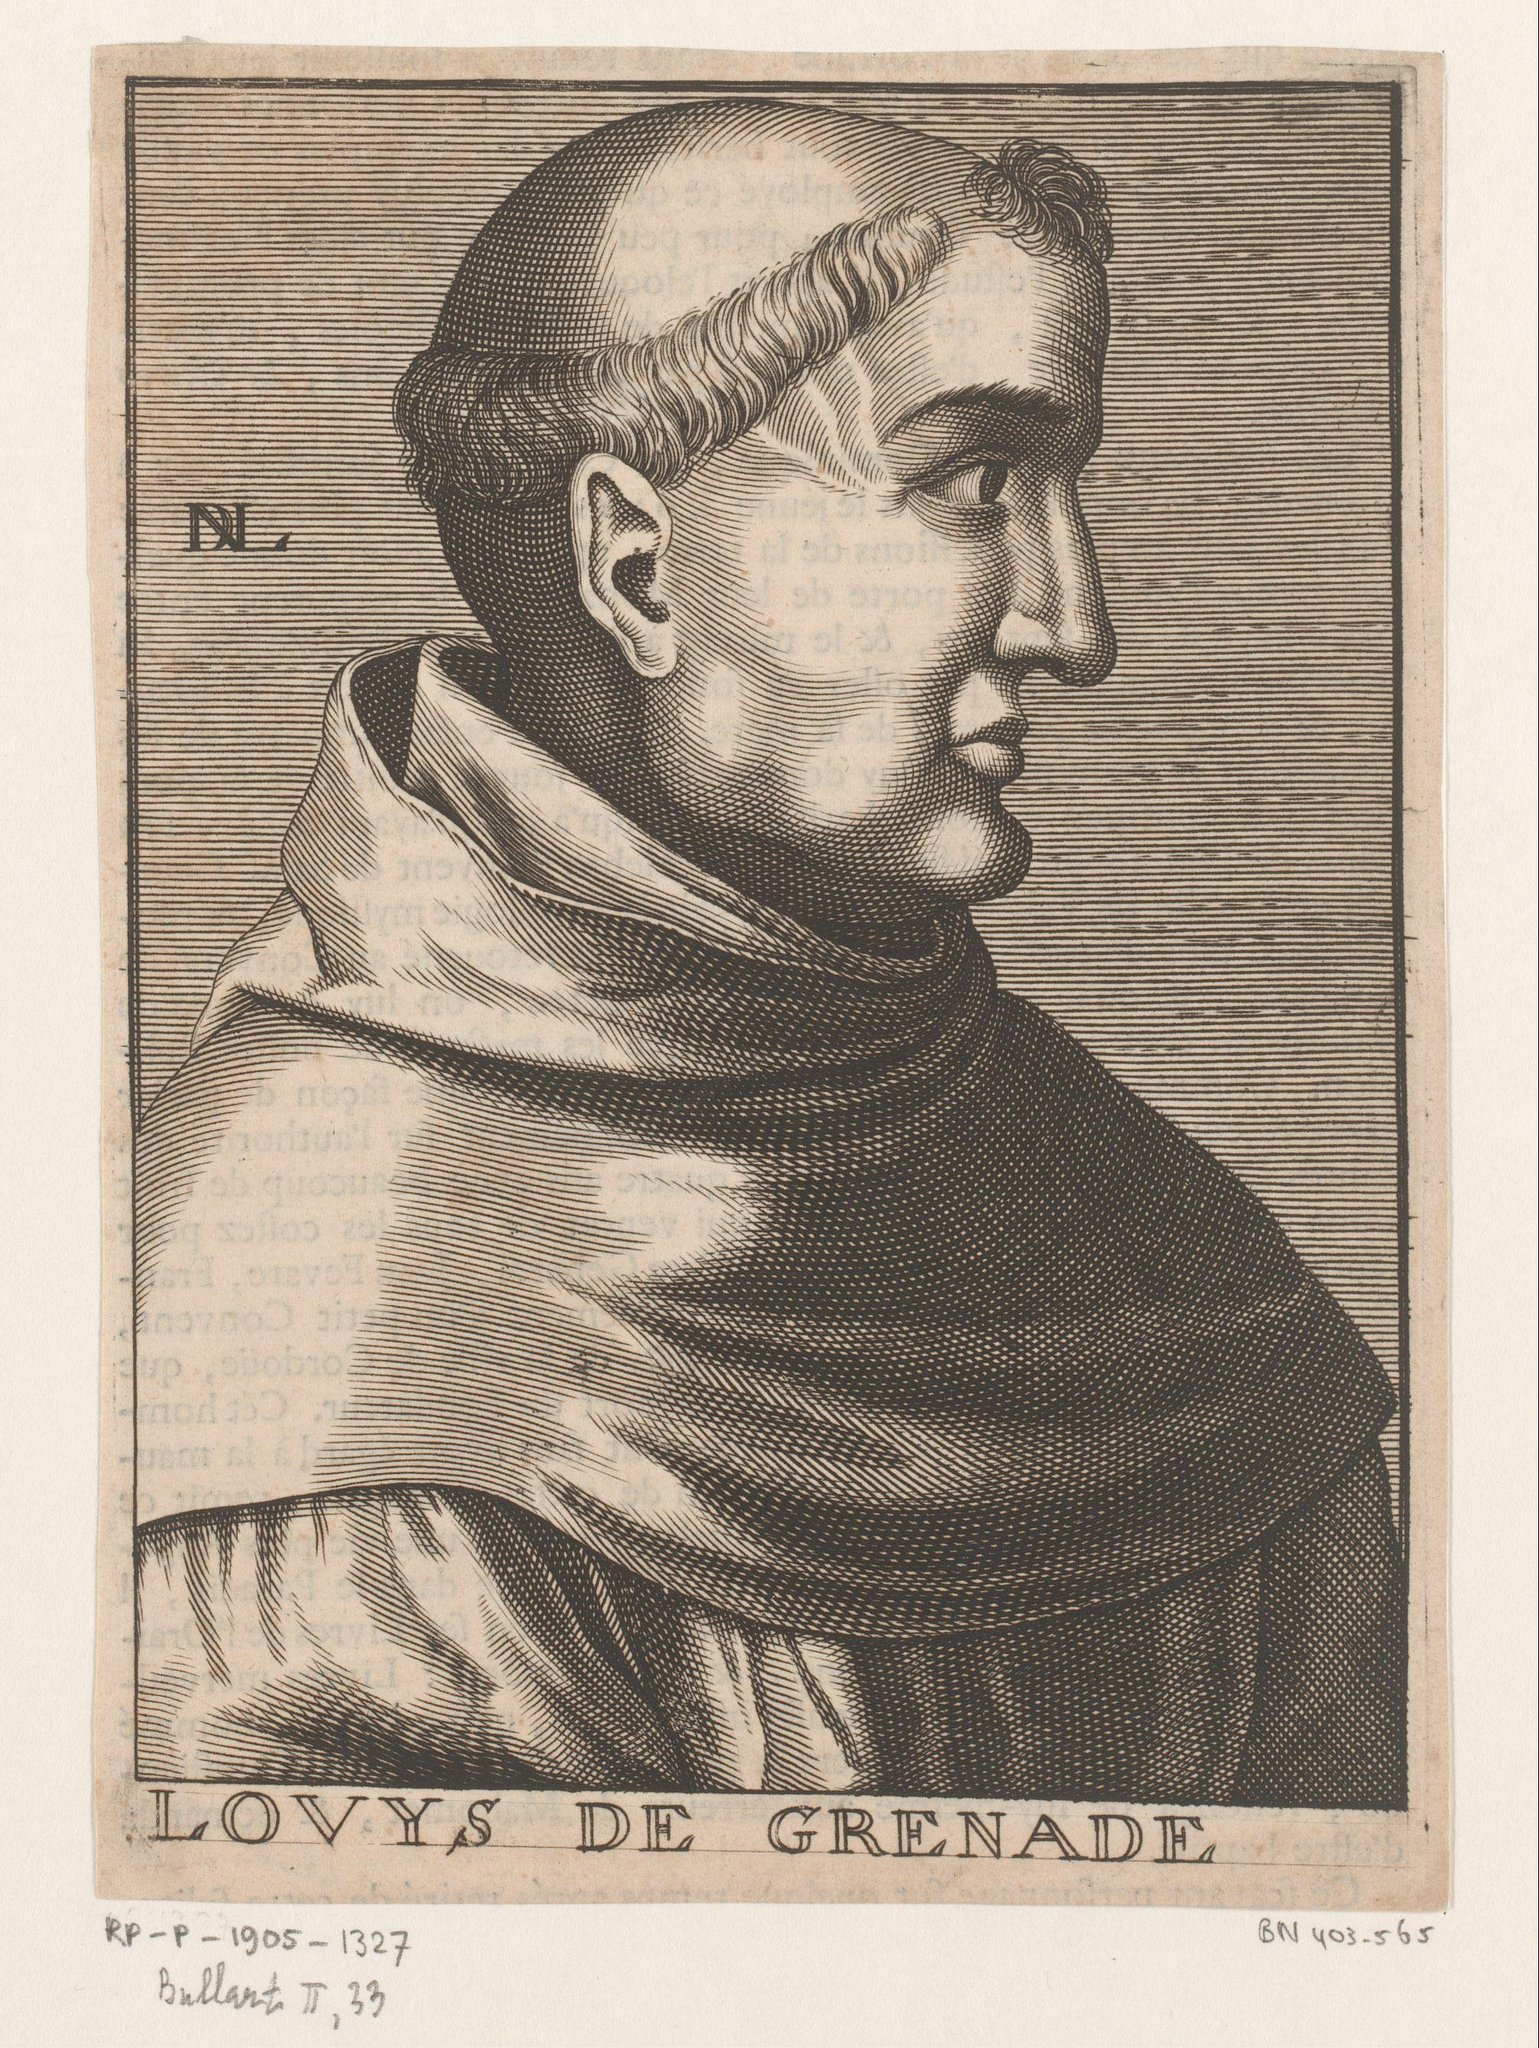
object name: book illustration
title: Louys de Grenade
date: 1682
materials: paper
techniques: engraving, letterpress printing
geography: brussels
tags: theologian, historical persons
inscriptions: collector's mark: Lugt 2228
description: Prent gebruikt voor: Bullart, Isaac. Académie des Sciences et Arts contenant les vies et éloges his. des hommes illustres qui ont excellé en ces professions depuis environ quatre siècles. Brussel: François Foppens, 1682. Het boek werd in 1682 eveneens in Amsterdam uitgegeven door de erfgenamen van Daniel Elzevier. Ieder portret betreft een illustratie bij de biografie van een kunstenaar of geleerde. De meeste portretten werden door Nicolas de Larmessin vervaardigd (162), 93 door De Boulonois en een derde door ongeïdentificeerde prentmakers. Dit betreft een illustratie op p. 33, deel II.